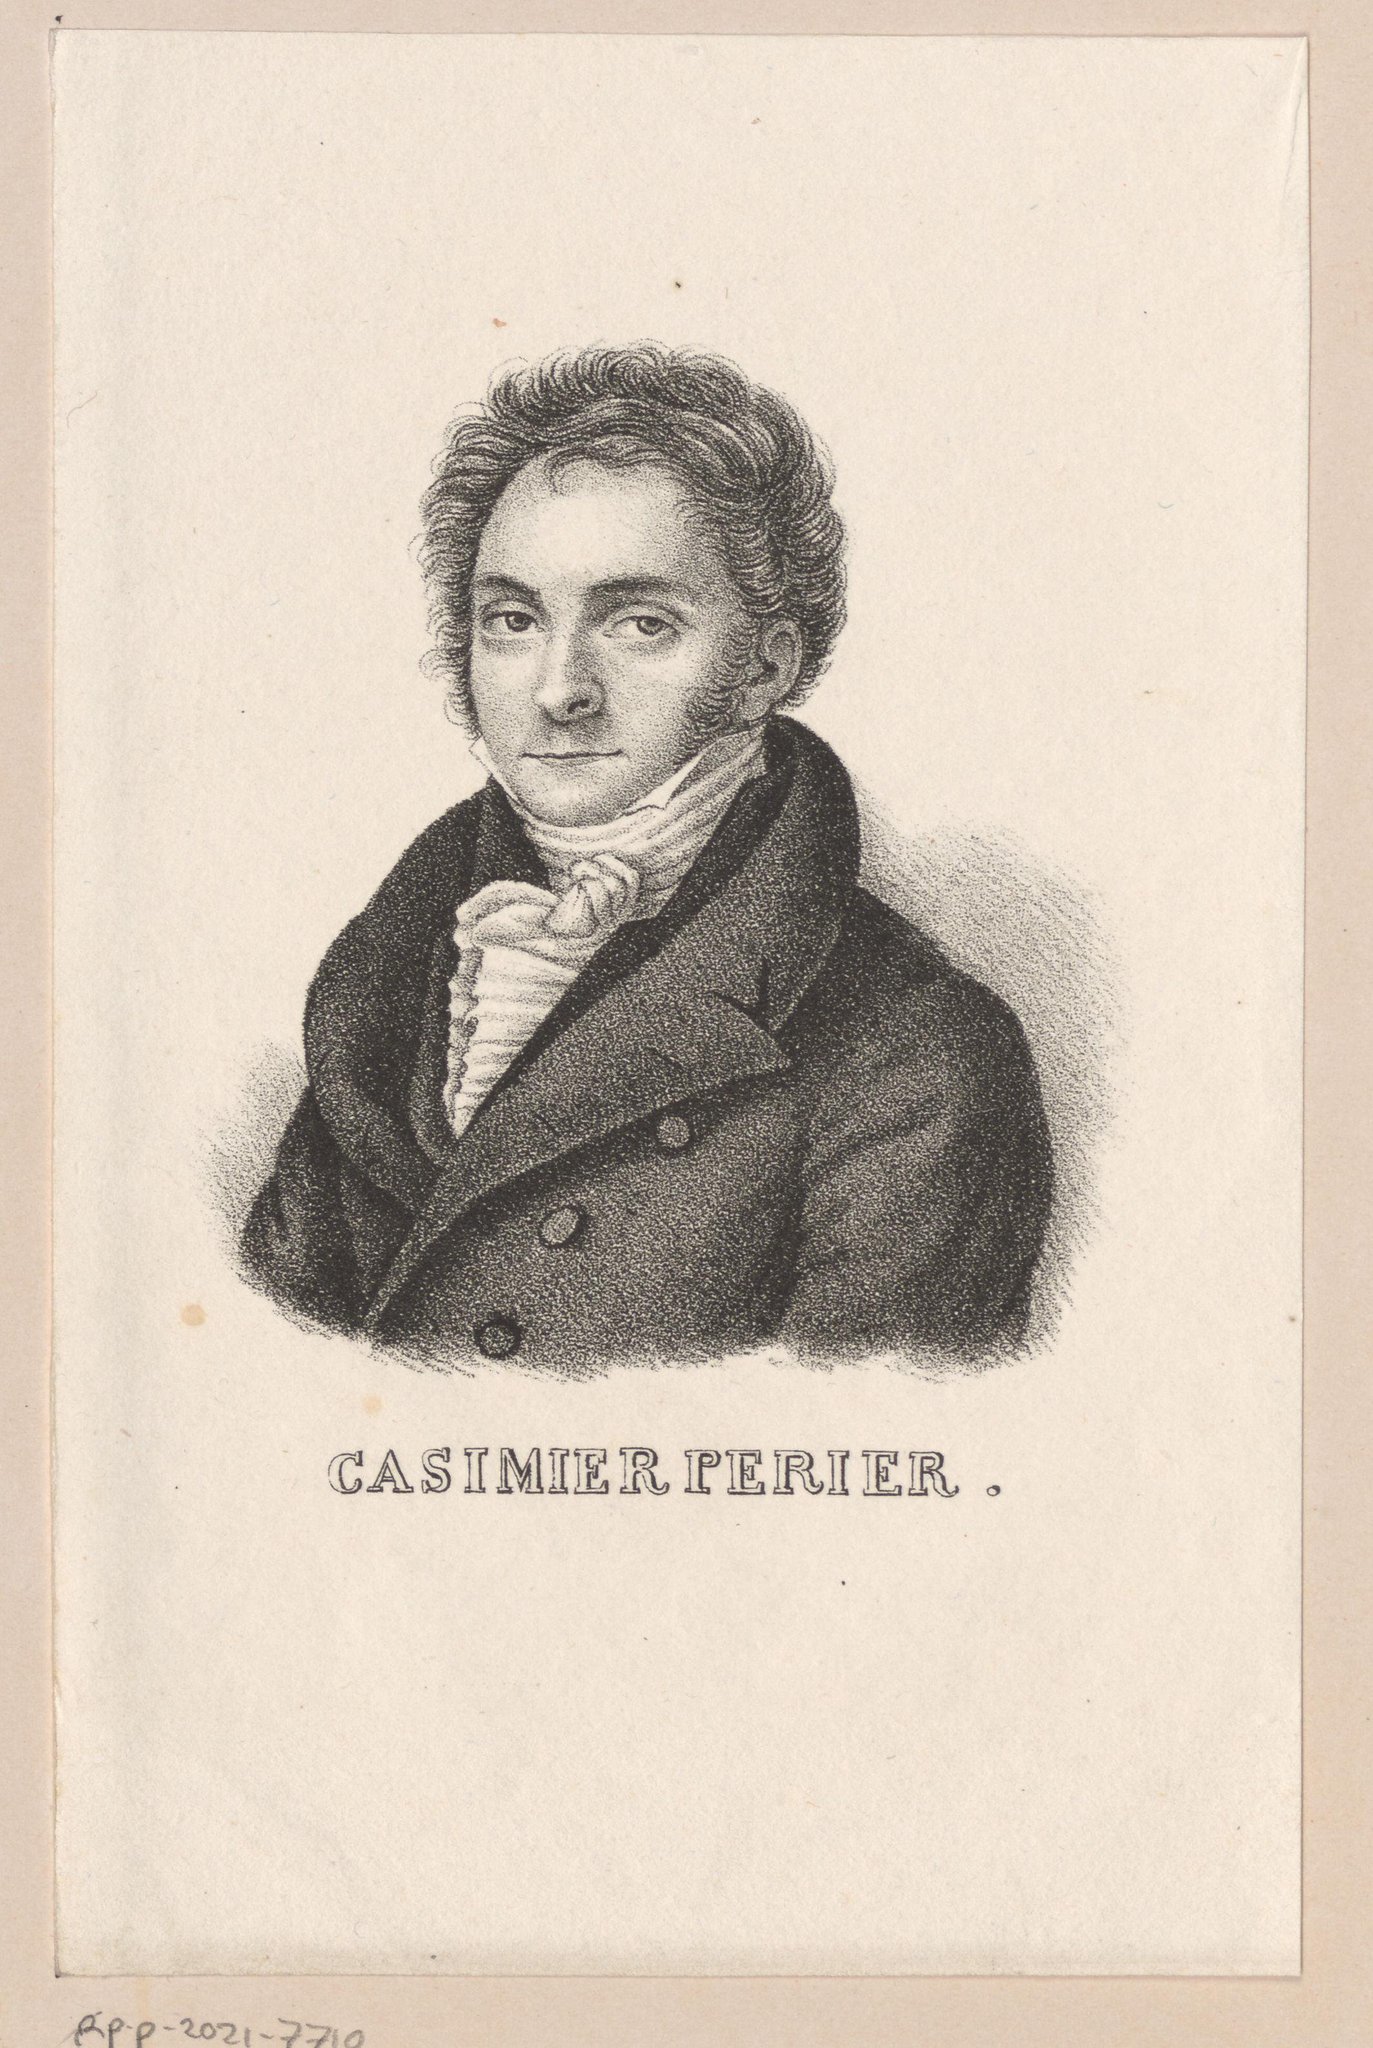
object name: print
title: Portret van Casimir-Pierre Périer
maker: Anonymous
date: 1820-1899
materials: paper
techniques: lithograph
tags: paris, politician, adult man, historical persons